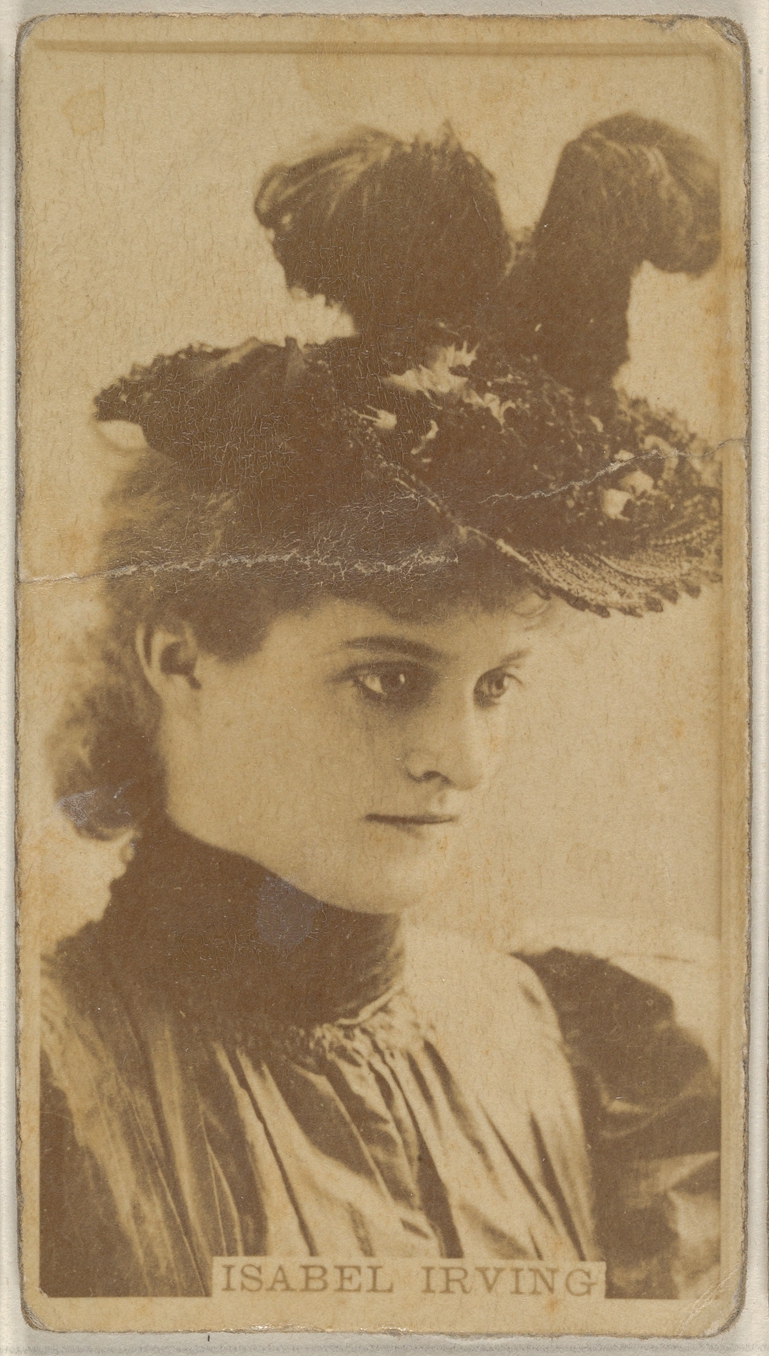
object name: photograph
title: Isabel Irving, from the Actors and Actresses series (N45, Type 8) for Virginia Brights Cigarettes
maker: allen & ginter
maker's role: publisher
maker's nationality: american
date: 1888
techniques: albumen silver print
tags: portraits,women,actresses